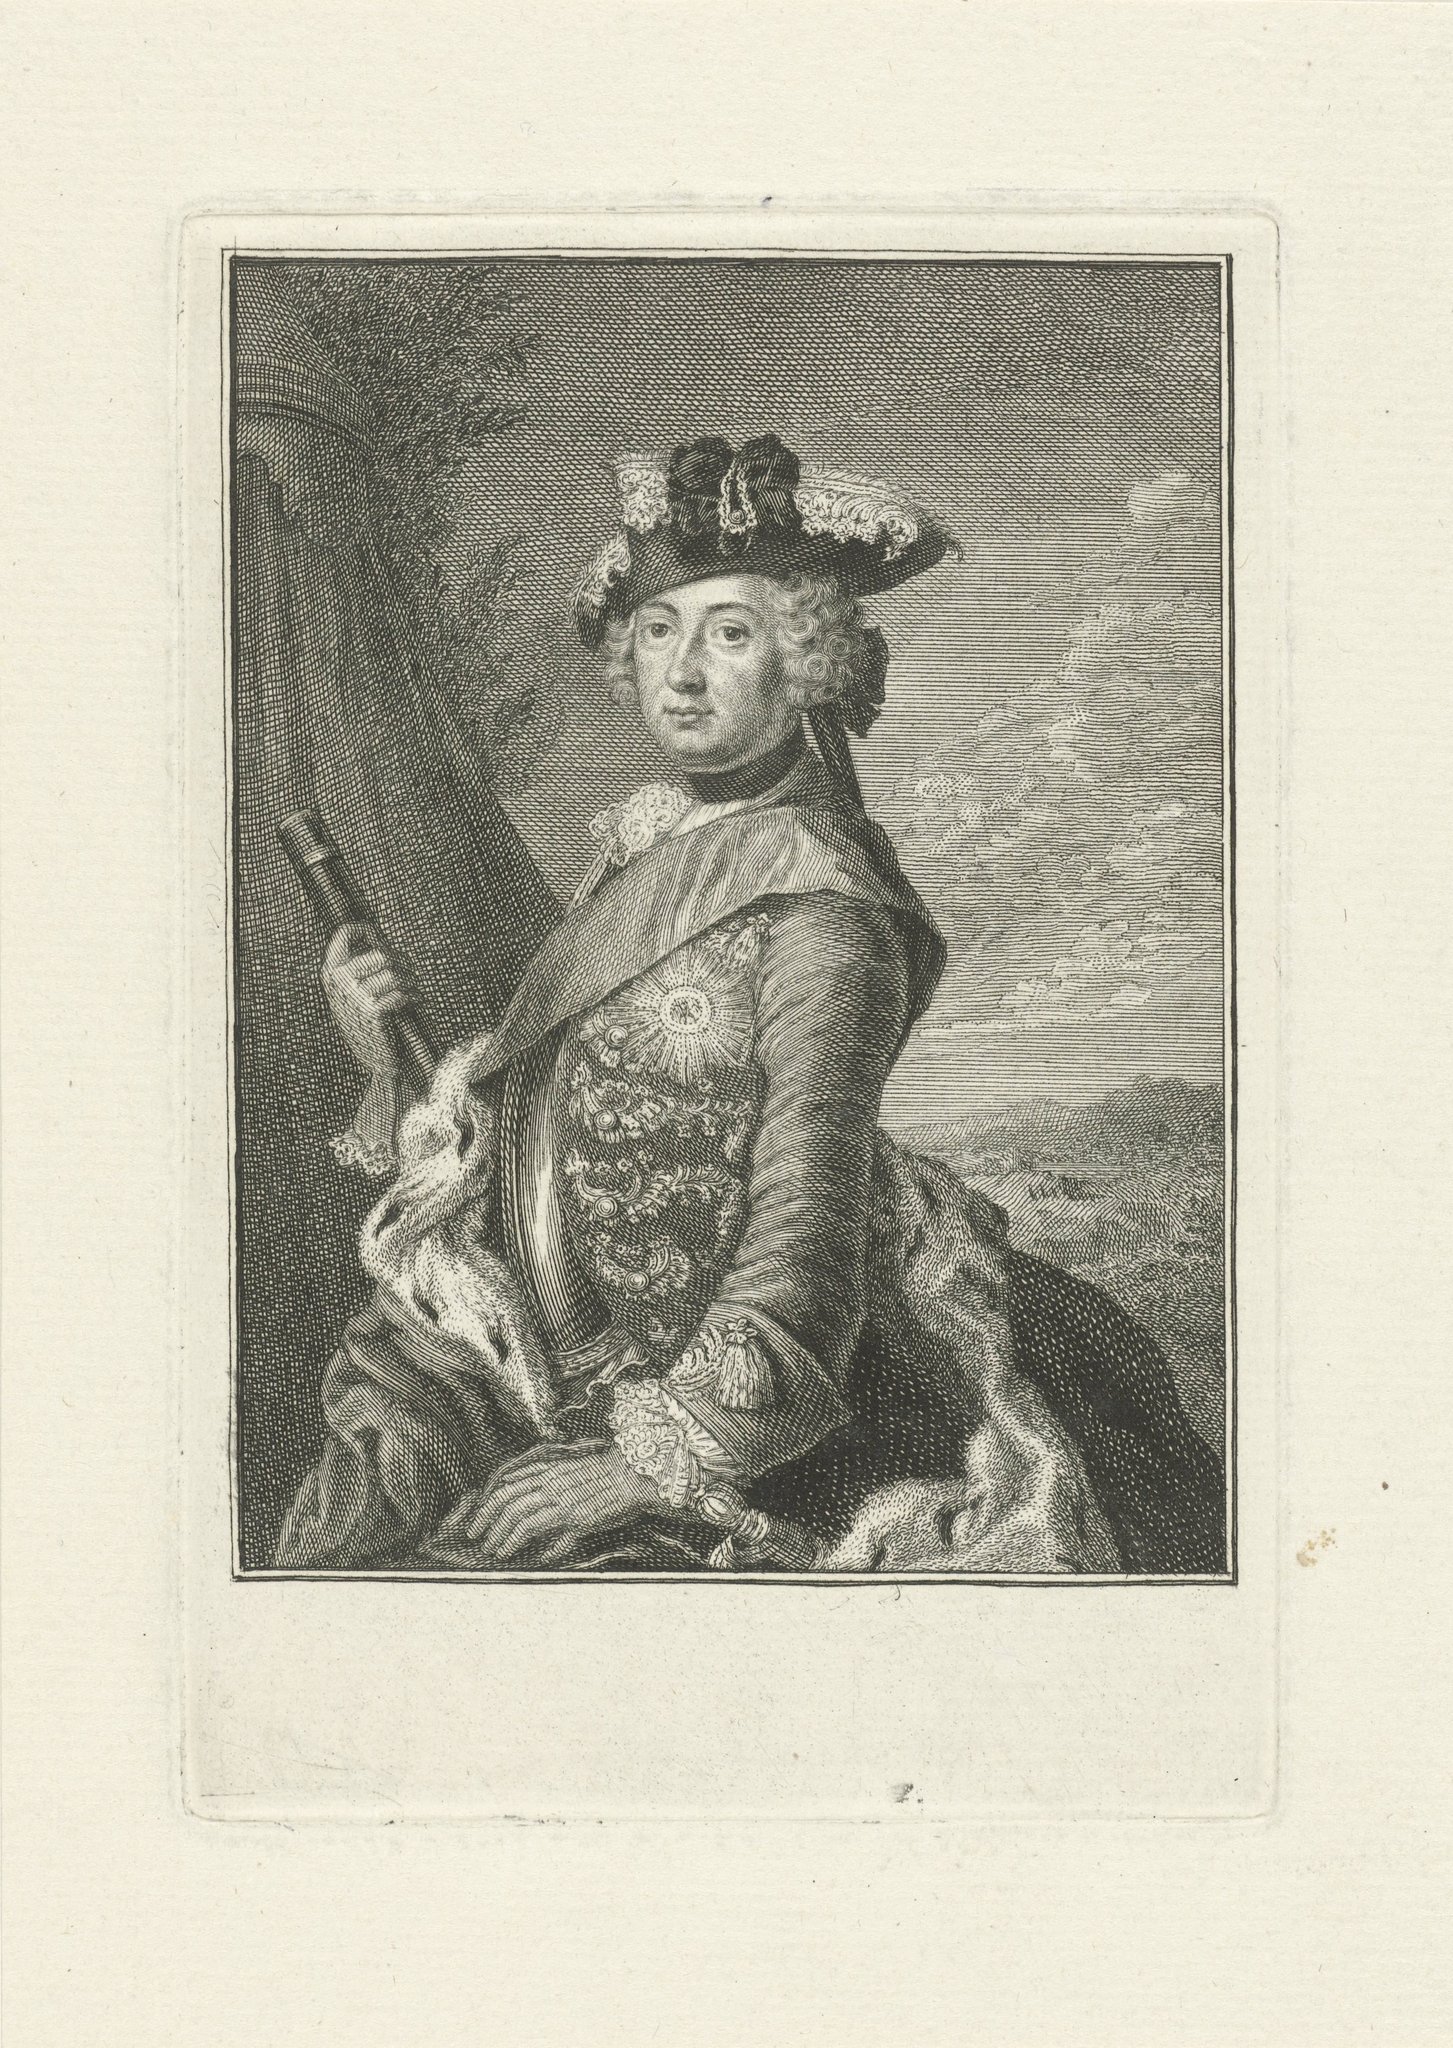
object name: print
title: Portret van Frederik II de Grote, koning van Pruisen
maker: jacob houbraken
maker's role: draughtsman, print maker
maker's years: 1698-1780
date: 1756-1758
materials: paper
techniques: engraving, etching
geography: amsterdam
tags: berlin, frederick ii (king of prussia), (military) camp with tents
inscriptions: collector's mark: Lugt 240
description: Frederik II de Grote, koning van Pruisen, in een landschap met links van hem een legertent. In zijn rechterhand houdt hij een commandostaf.